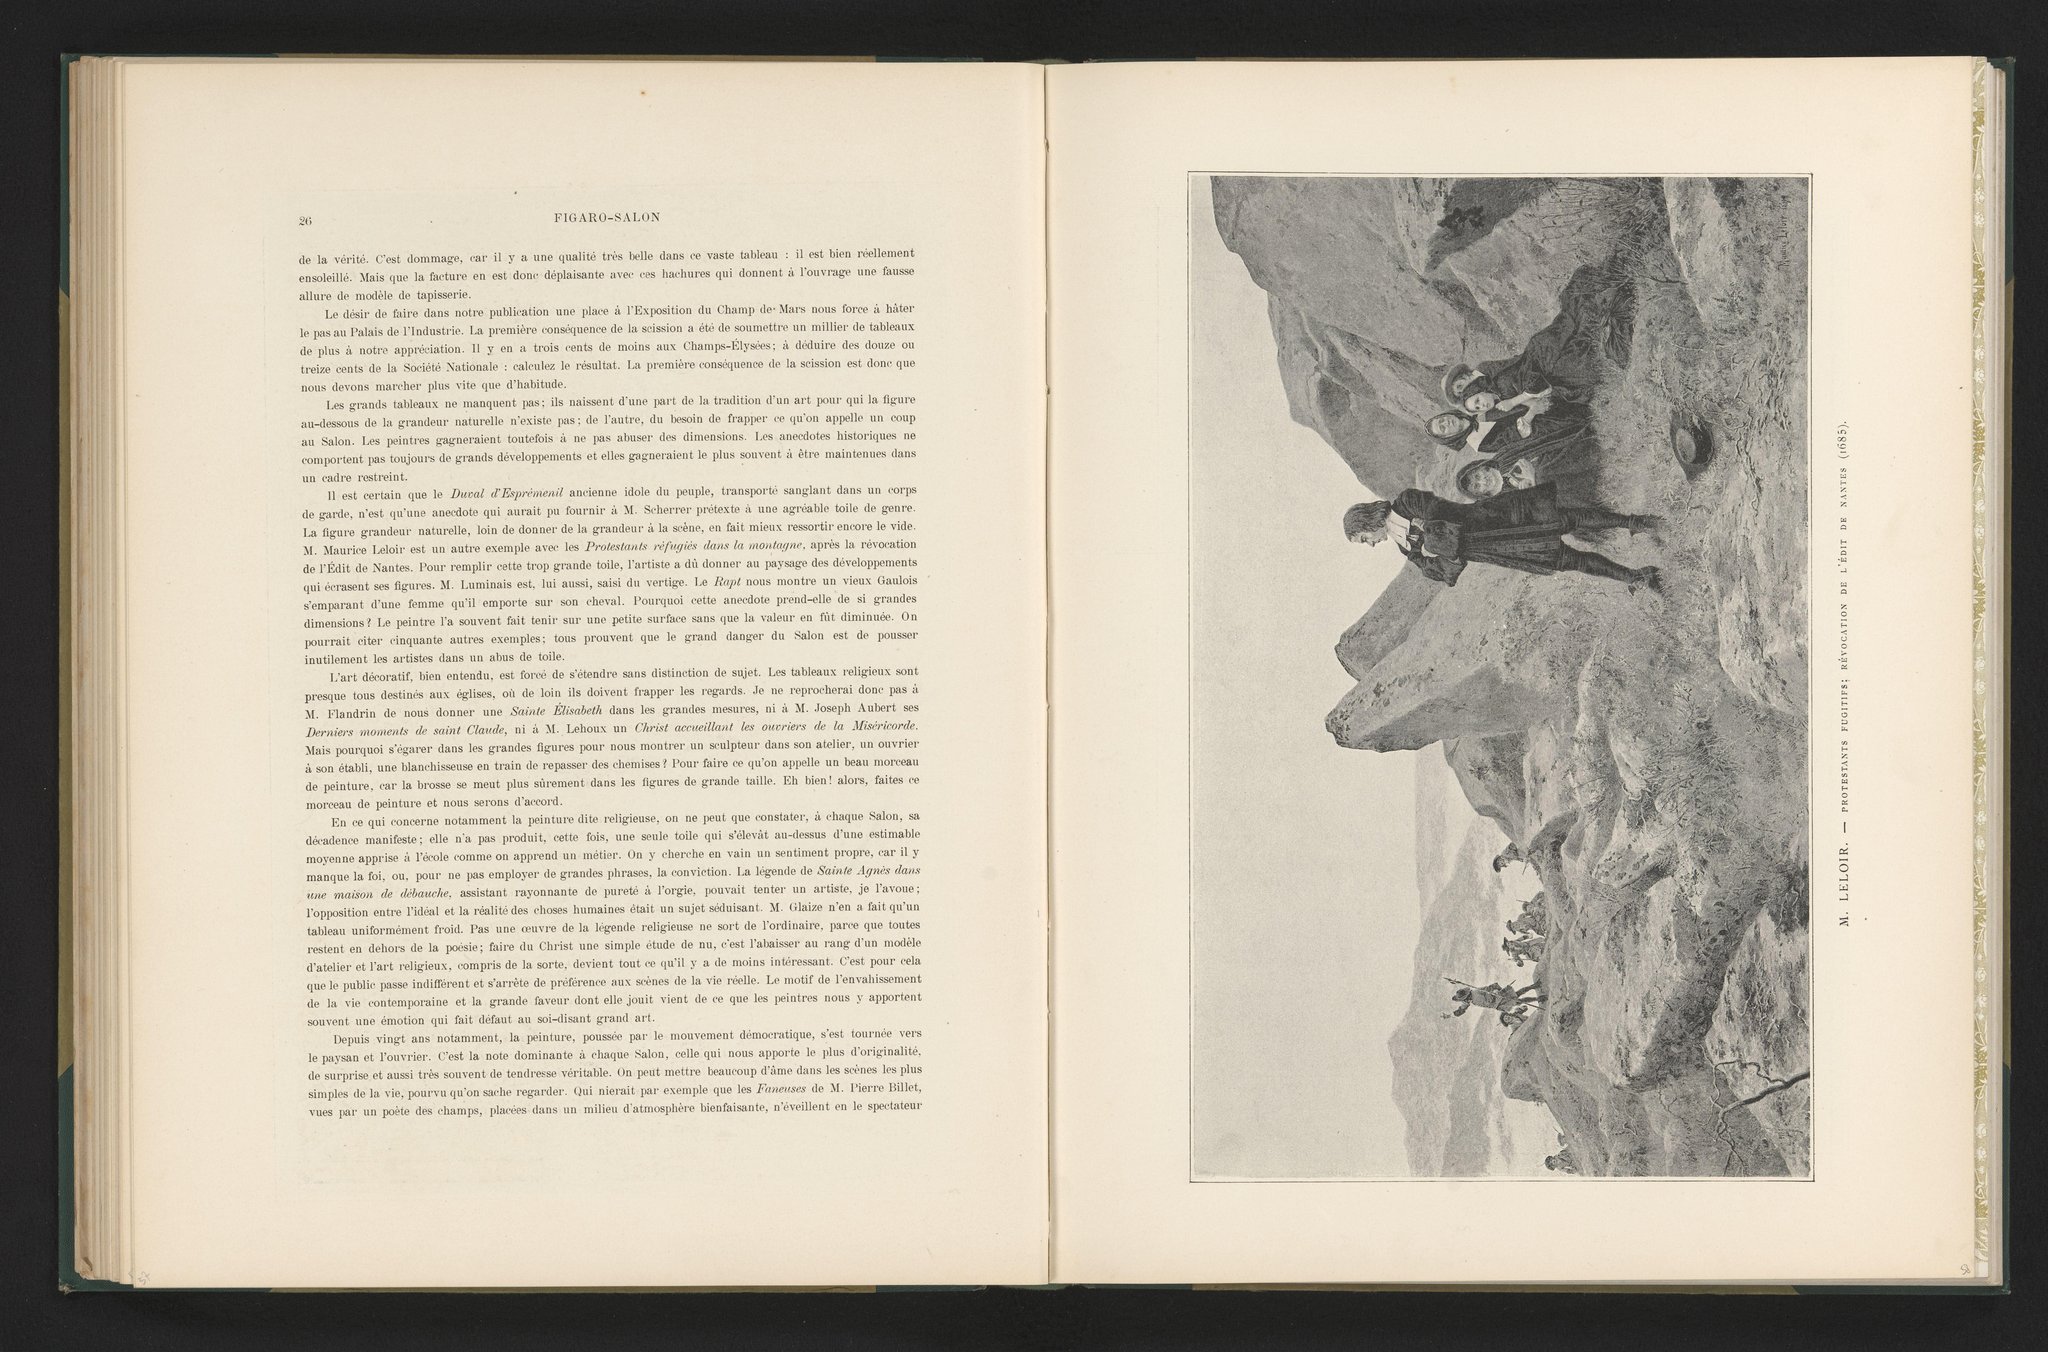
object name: page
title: Reproductie van een schilderij van voortvluchtige protestanten tijdens de herroeping van het Edict van Nantes door Maurice Leloir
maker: Anonymous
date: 1885-1901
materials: paper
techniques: autotype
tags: fugitives 'en route', flight, running away; pursuing, mountains (+ landscape with figures, staffage)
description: Prent op pagina 27 van Figaro-Salon (par Albert Wolff).